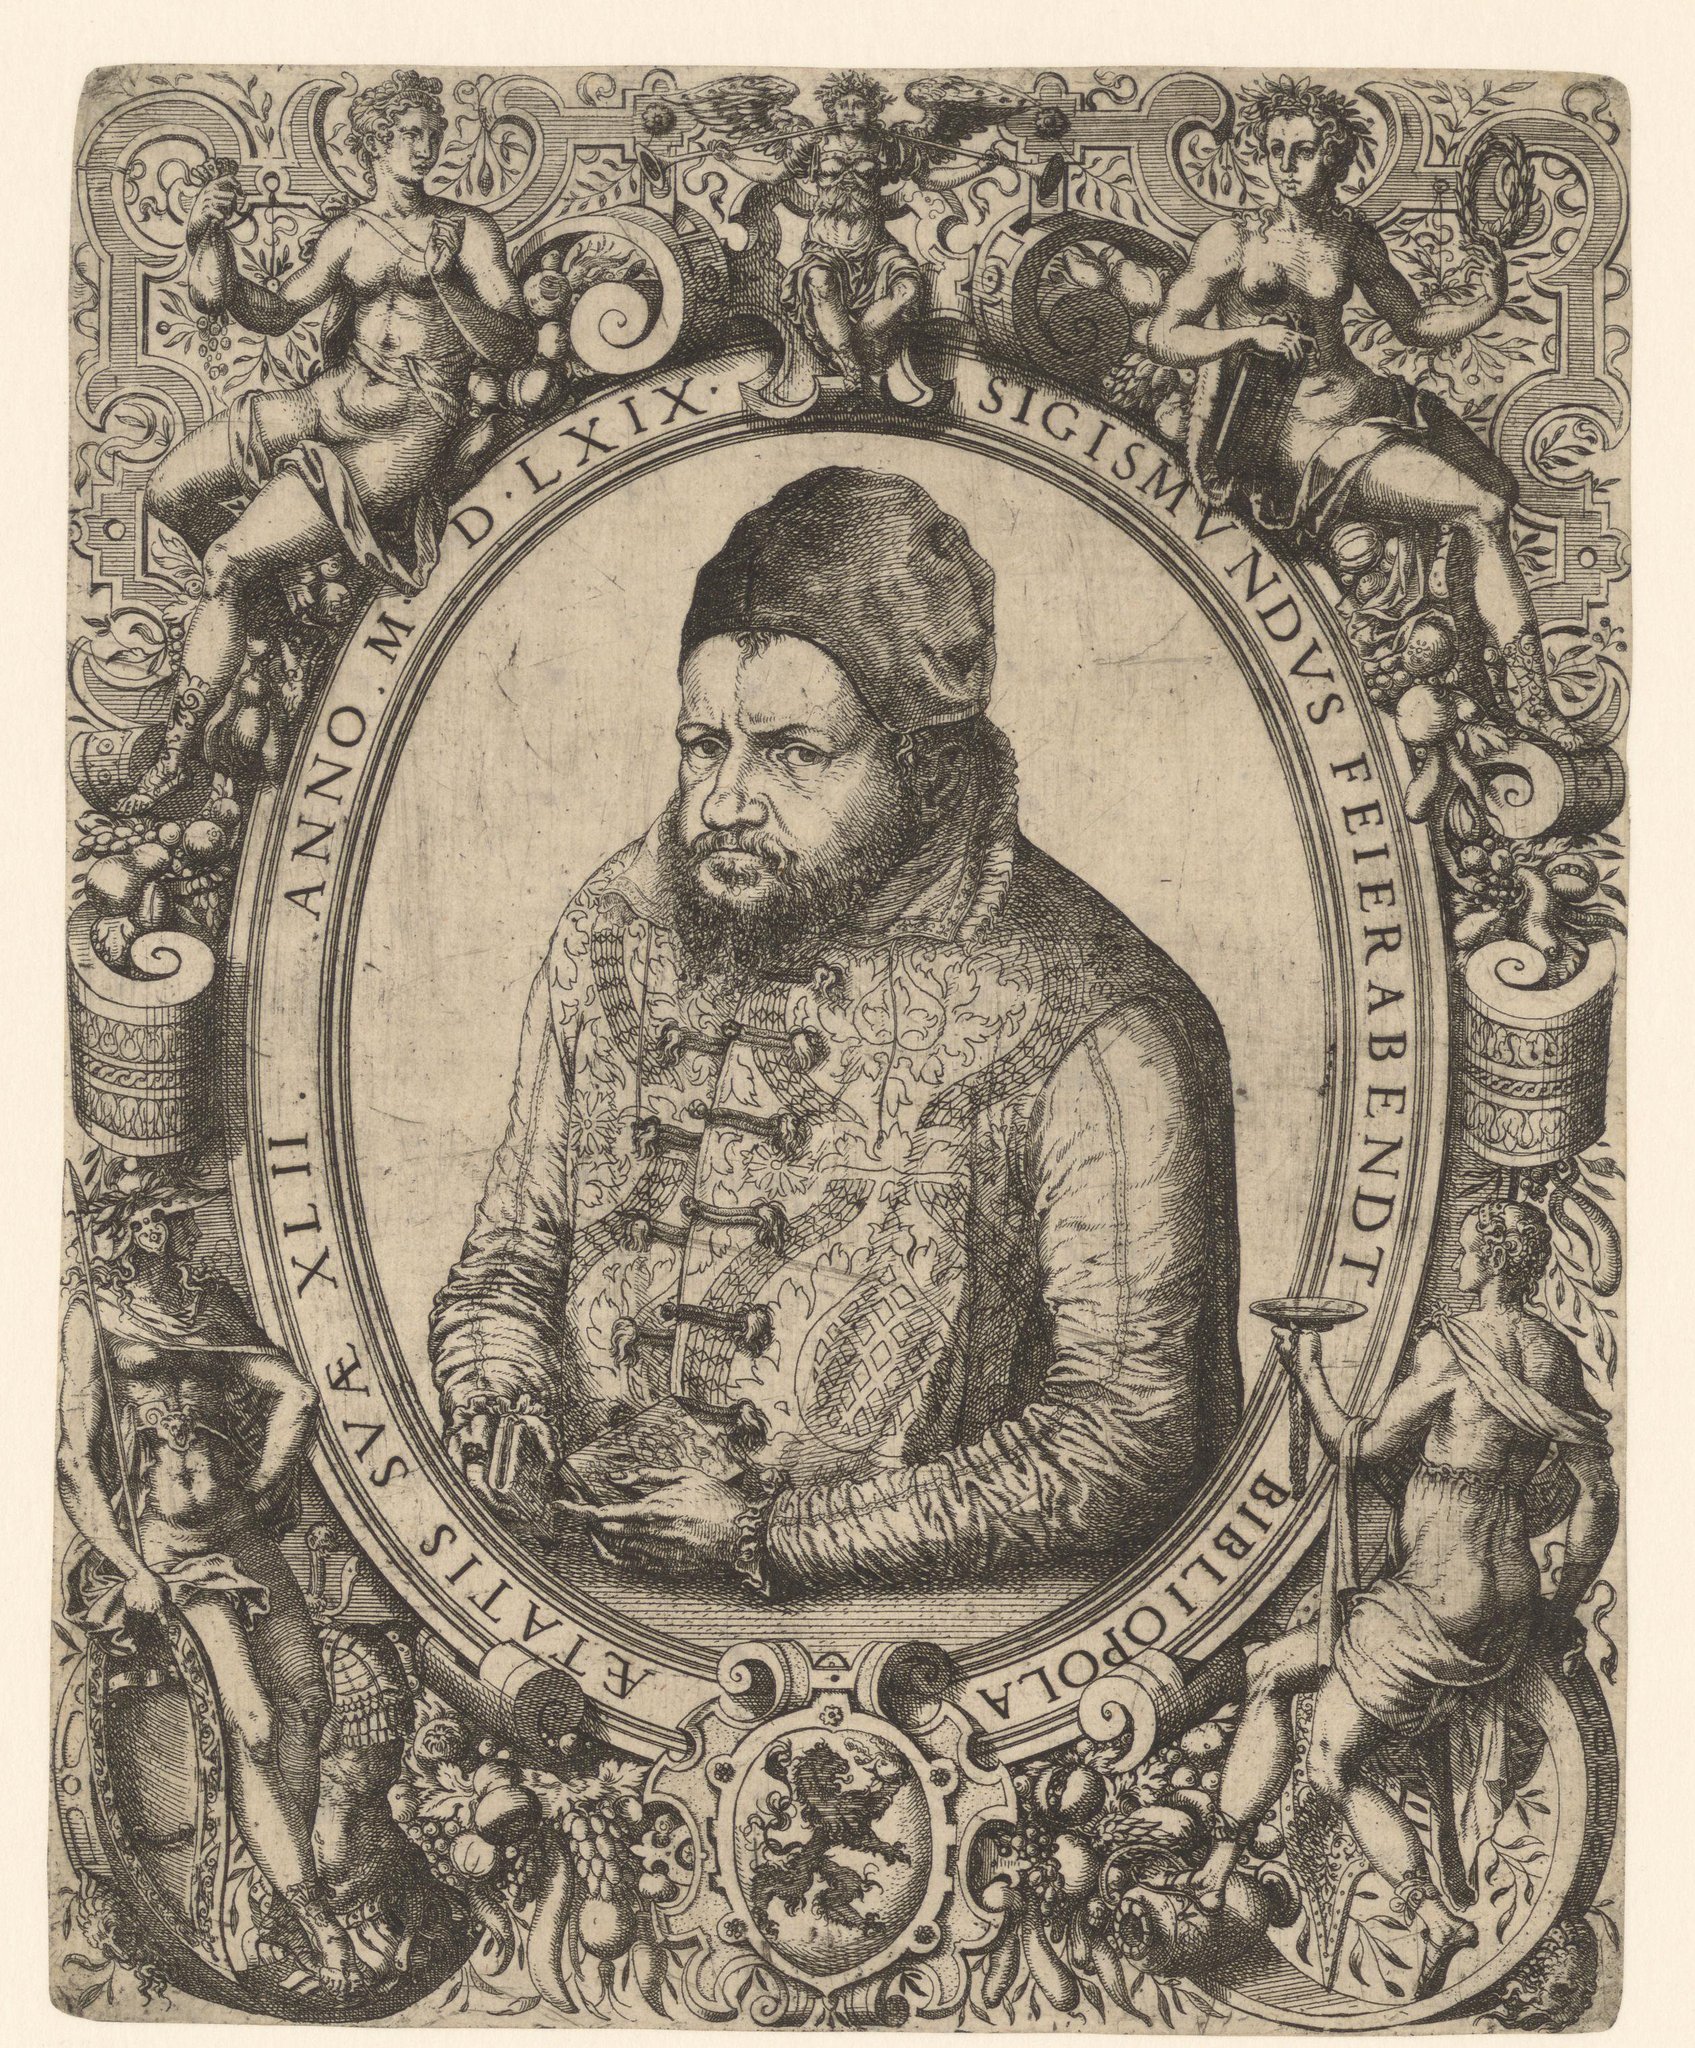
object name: print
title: Portret van Sigmund Feyerabend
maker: jost amman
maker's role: draughtsman, painter, print maker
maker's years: 1539-1591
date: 1569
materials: paper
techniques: etching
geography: nuremberg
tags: printer, publisher, bookseller, sigmund feyerabend, historical persons, device (trade-mark of printer or publisher), book, fame; 'fama', 'fama buona', 'fama chiara' (ripa), armorial bearing, heraldry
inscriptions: collector's mark: Lugt 2760, collector's mark: Lugt 2228, collector's mark: Lugt 2228, collector's mark: ‘Sammlung / Reinhard Piper / München’ Lugt 5594, watermark